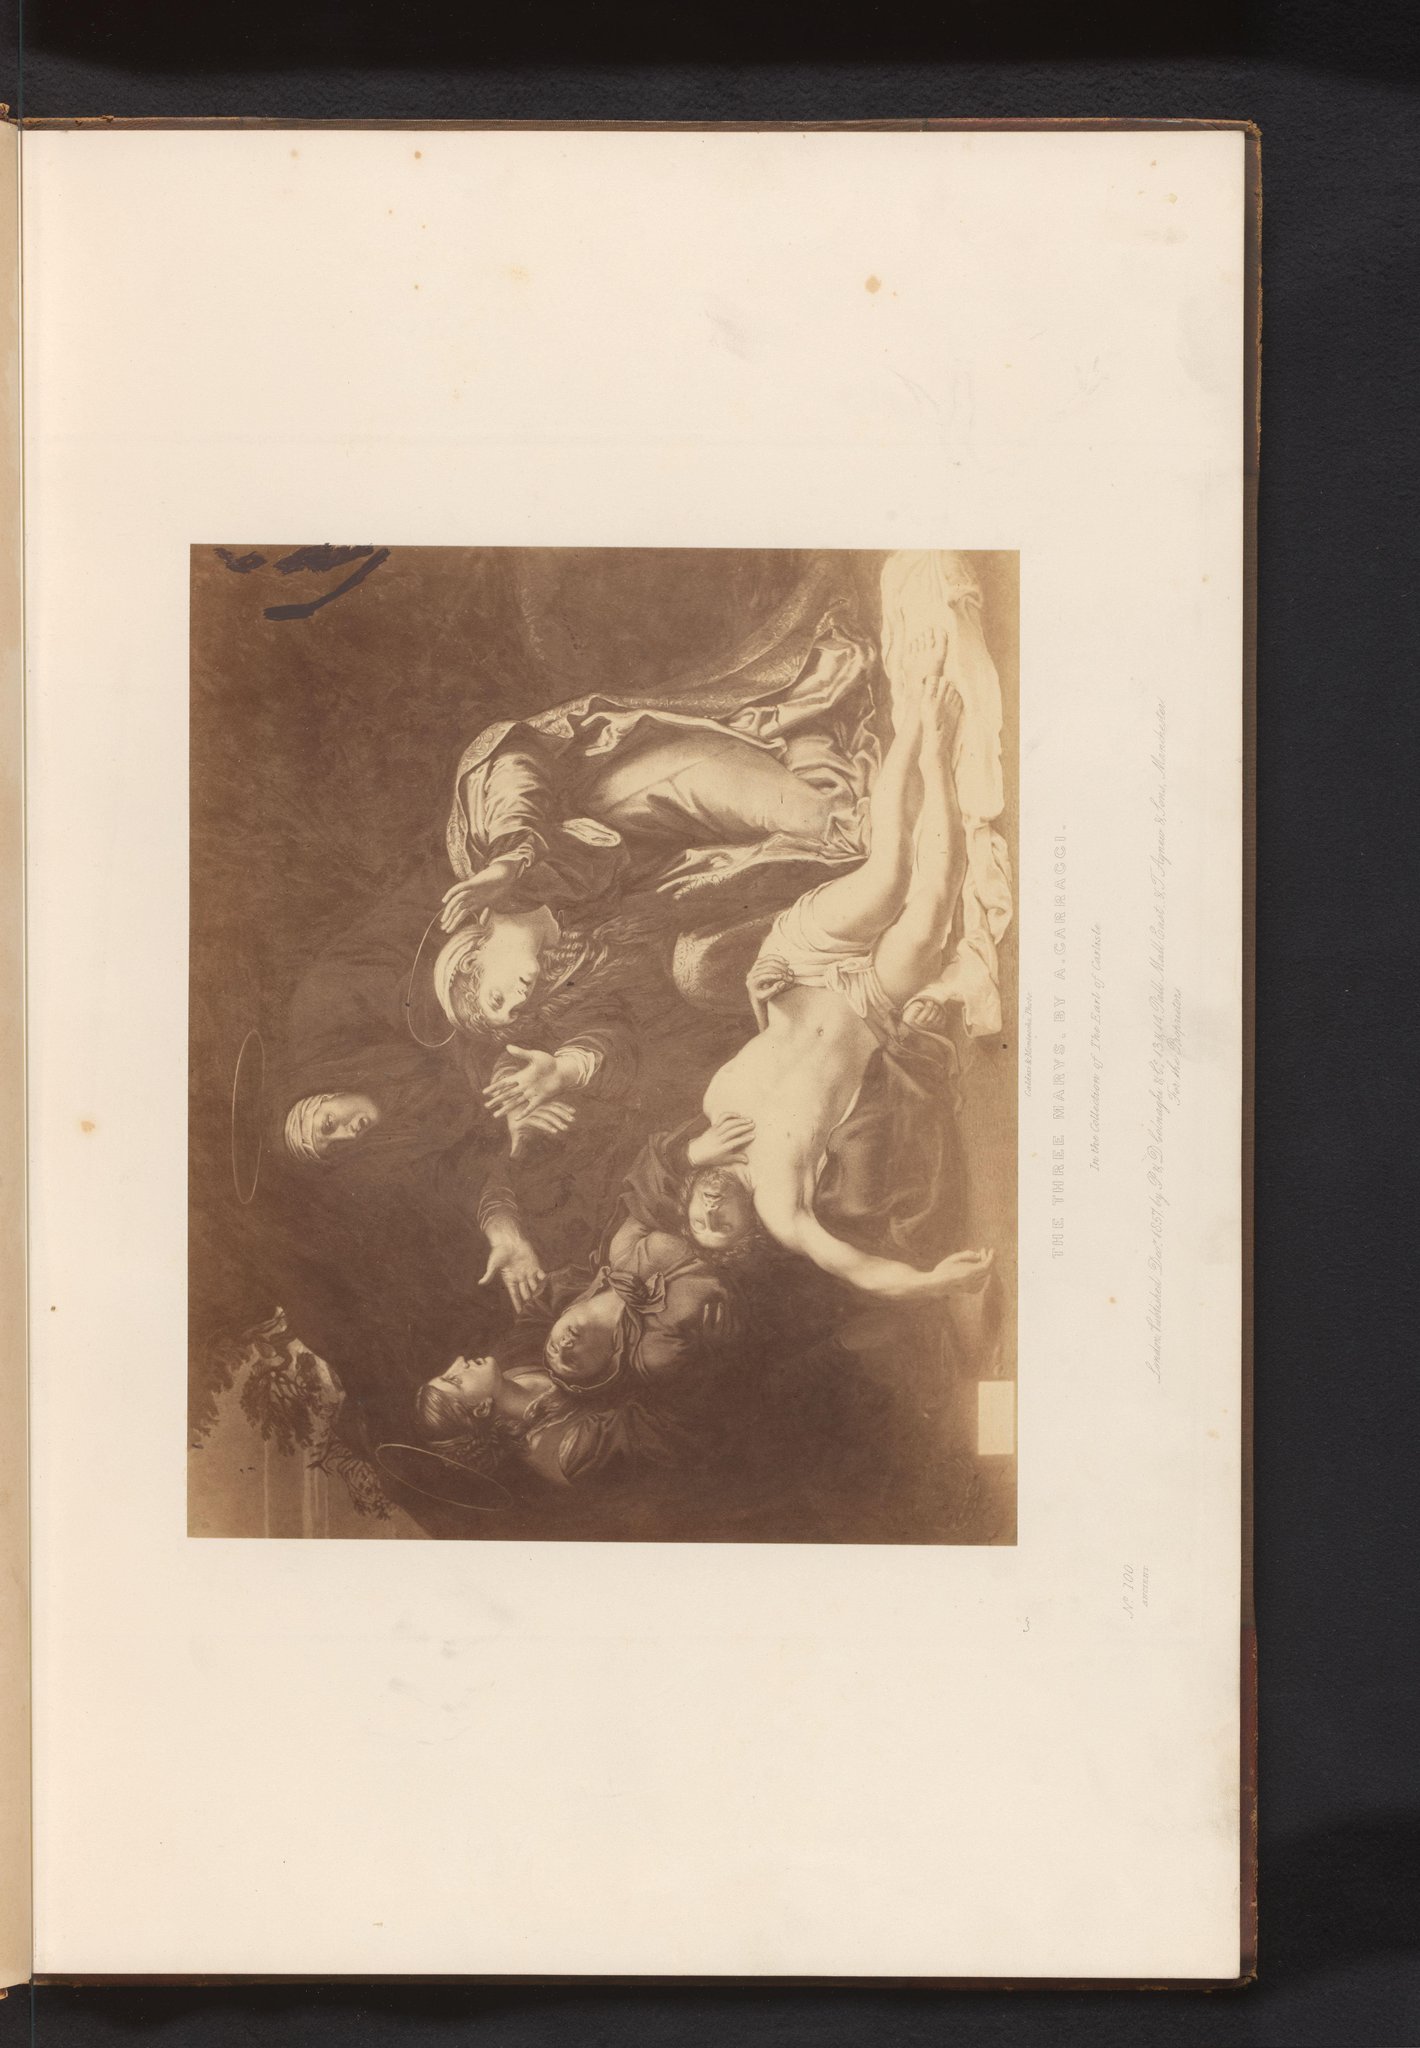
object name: page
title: The Three Marys, by A. Carracci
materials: photographic support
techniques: albumen print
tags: the holy women (the three maries) on their way to or at the tomb, to anoint christ's body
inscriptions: number: ‘3’, inscription: ‘In the Collection of The Earl of Carlisle./ London, Published Decr, 1857, by P. & D. Colnaghi & Co, 13 & 14, Pall Mall East & T. Agneur & Sons, Manchester./ For the Proprietors.’, number: ‘No. 100/ ANCIENT.’